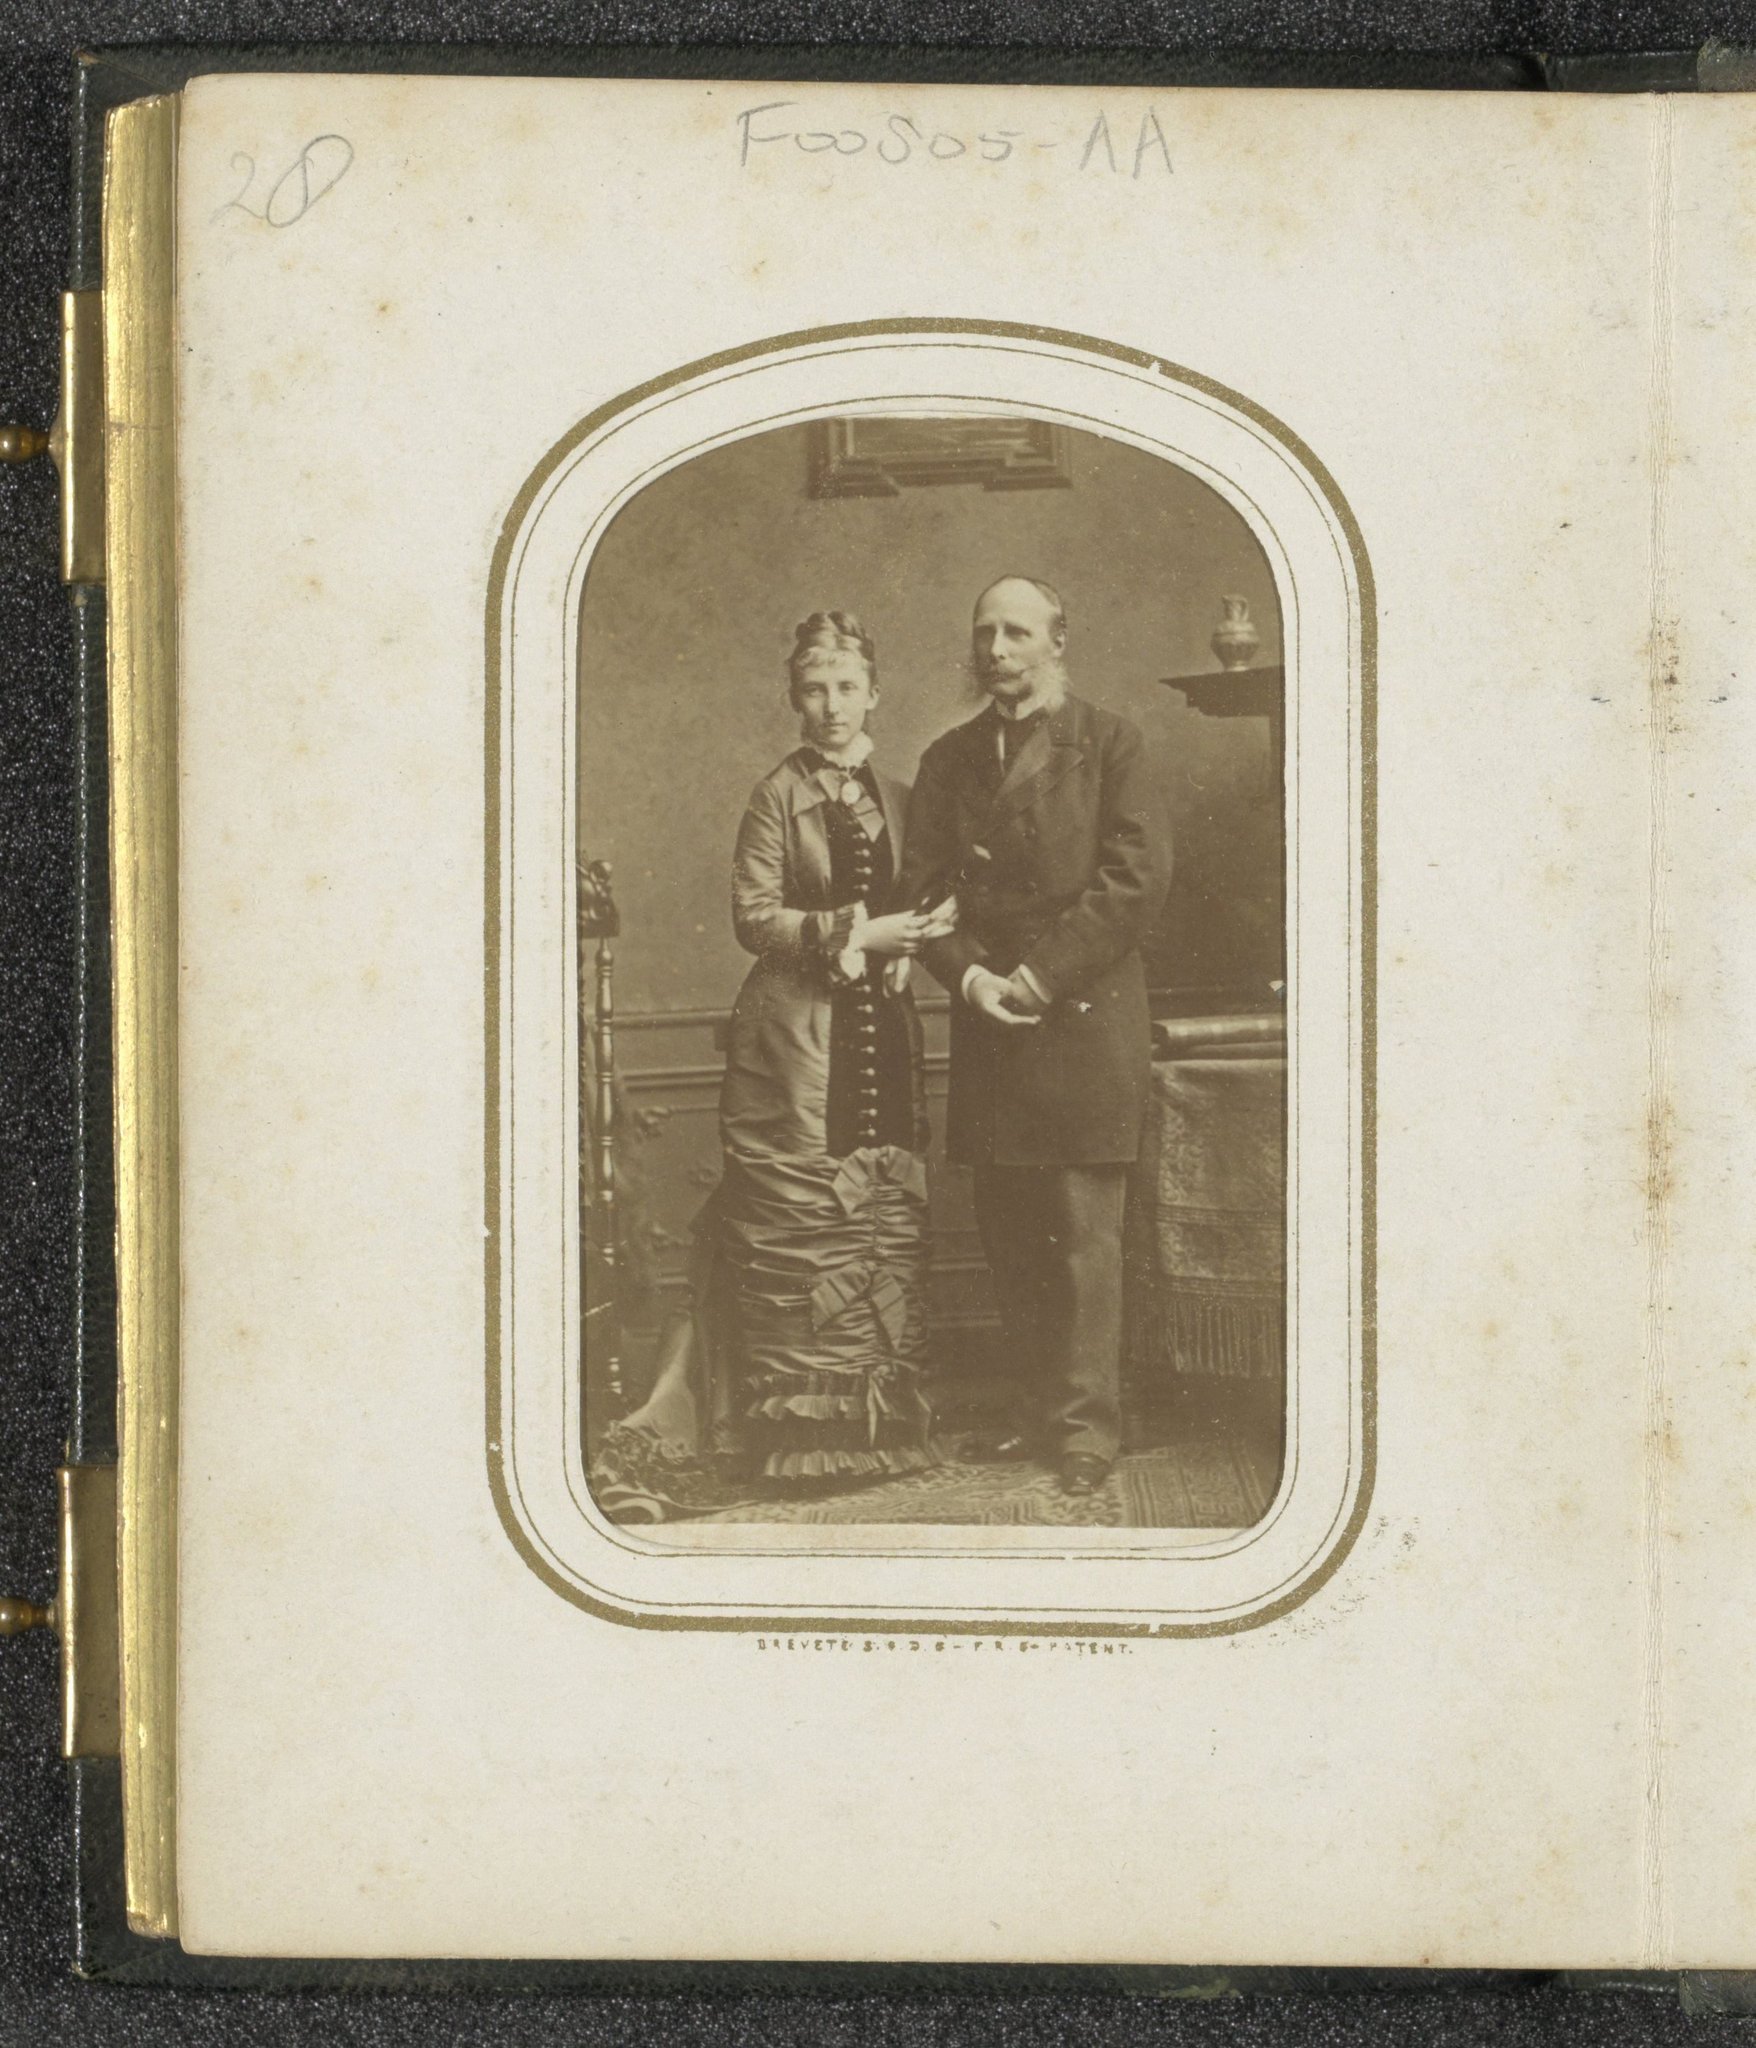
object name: carte de visite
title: Portret van prins Hendrik, broer van Koning Willem III, en zijn echtgenote Maria van Pruisen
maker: Anonymous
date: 1880-1890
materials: cardboard, paper, photographic support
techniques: albumen print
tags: hendrik (prins der nederlanden), sideburns, studio requisites ~ photographer, trousers, breeches, moustache, prince, historical persons, styles of hairdress - aa - ~ women, marriage, married couple, 'matrimonium', princess, dress, gown, coat, cape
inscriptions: inscription: ‘Prins Hendrik (1820-1879) broeder van Koning Willem III & Louisa van Pruisen’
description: Onderdeel van Fotoalbum met 29 foto's van Nederlandse vorsten.